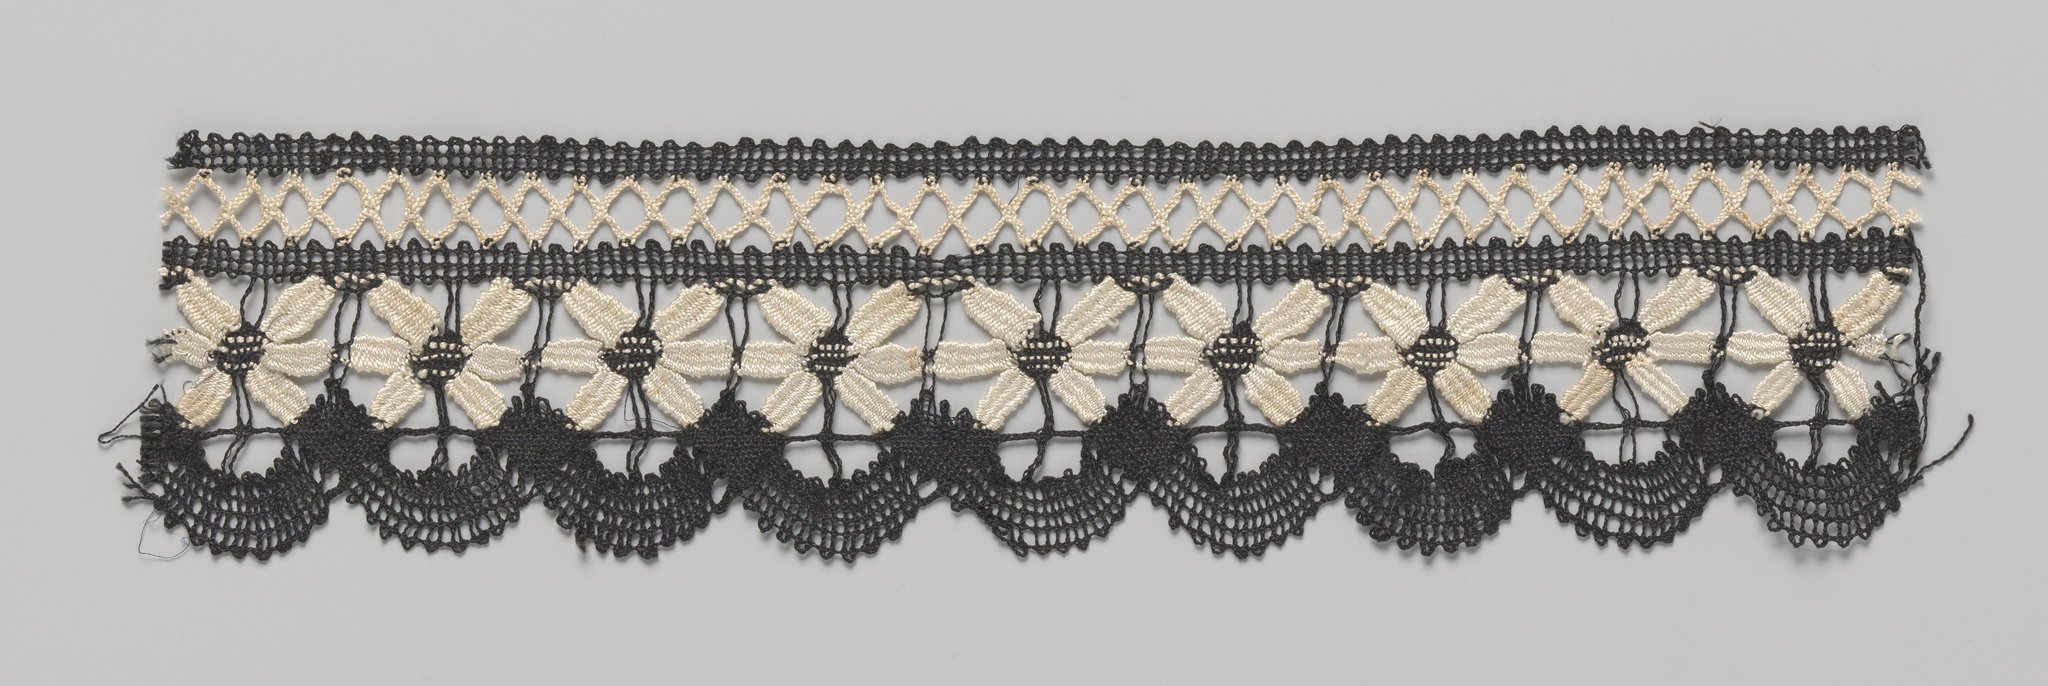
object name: strip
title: Strook zwart-witte kloskant met één rij margrieten boven halfronde schulpen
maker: Anonymous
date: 1870-1890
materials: silk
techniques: lace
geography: le puy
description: Strook zwart-witte kloskant: Cluny-kant. Het zich herhalende patroon bestaat uit aaneengeschakelde vierkantjes met in elk een witte margriet met een zwart bloemhart. Onder elk vierkantje een boogje. Deze boogjes vormen de schulpenrand. Boven de rij bloemen een netwerk van witte ruiten tussen twee zwarte gekloste bandjes.